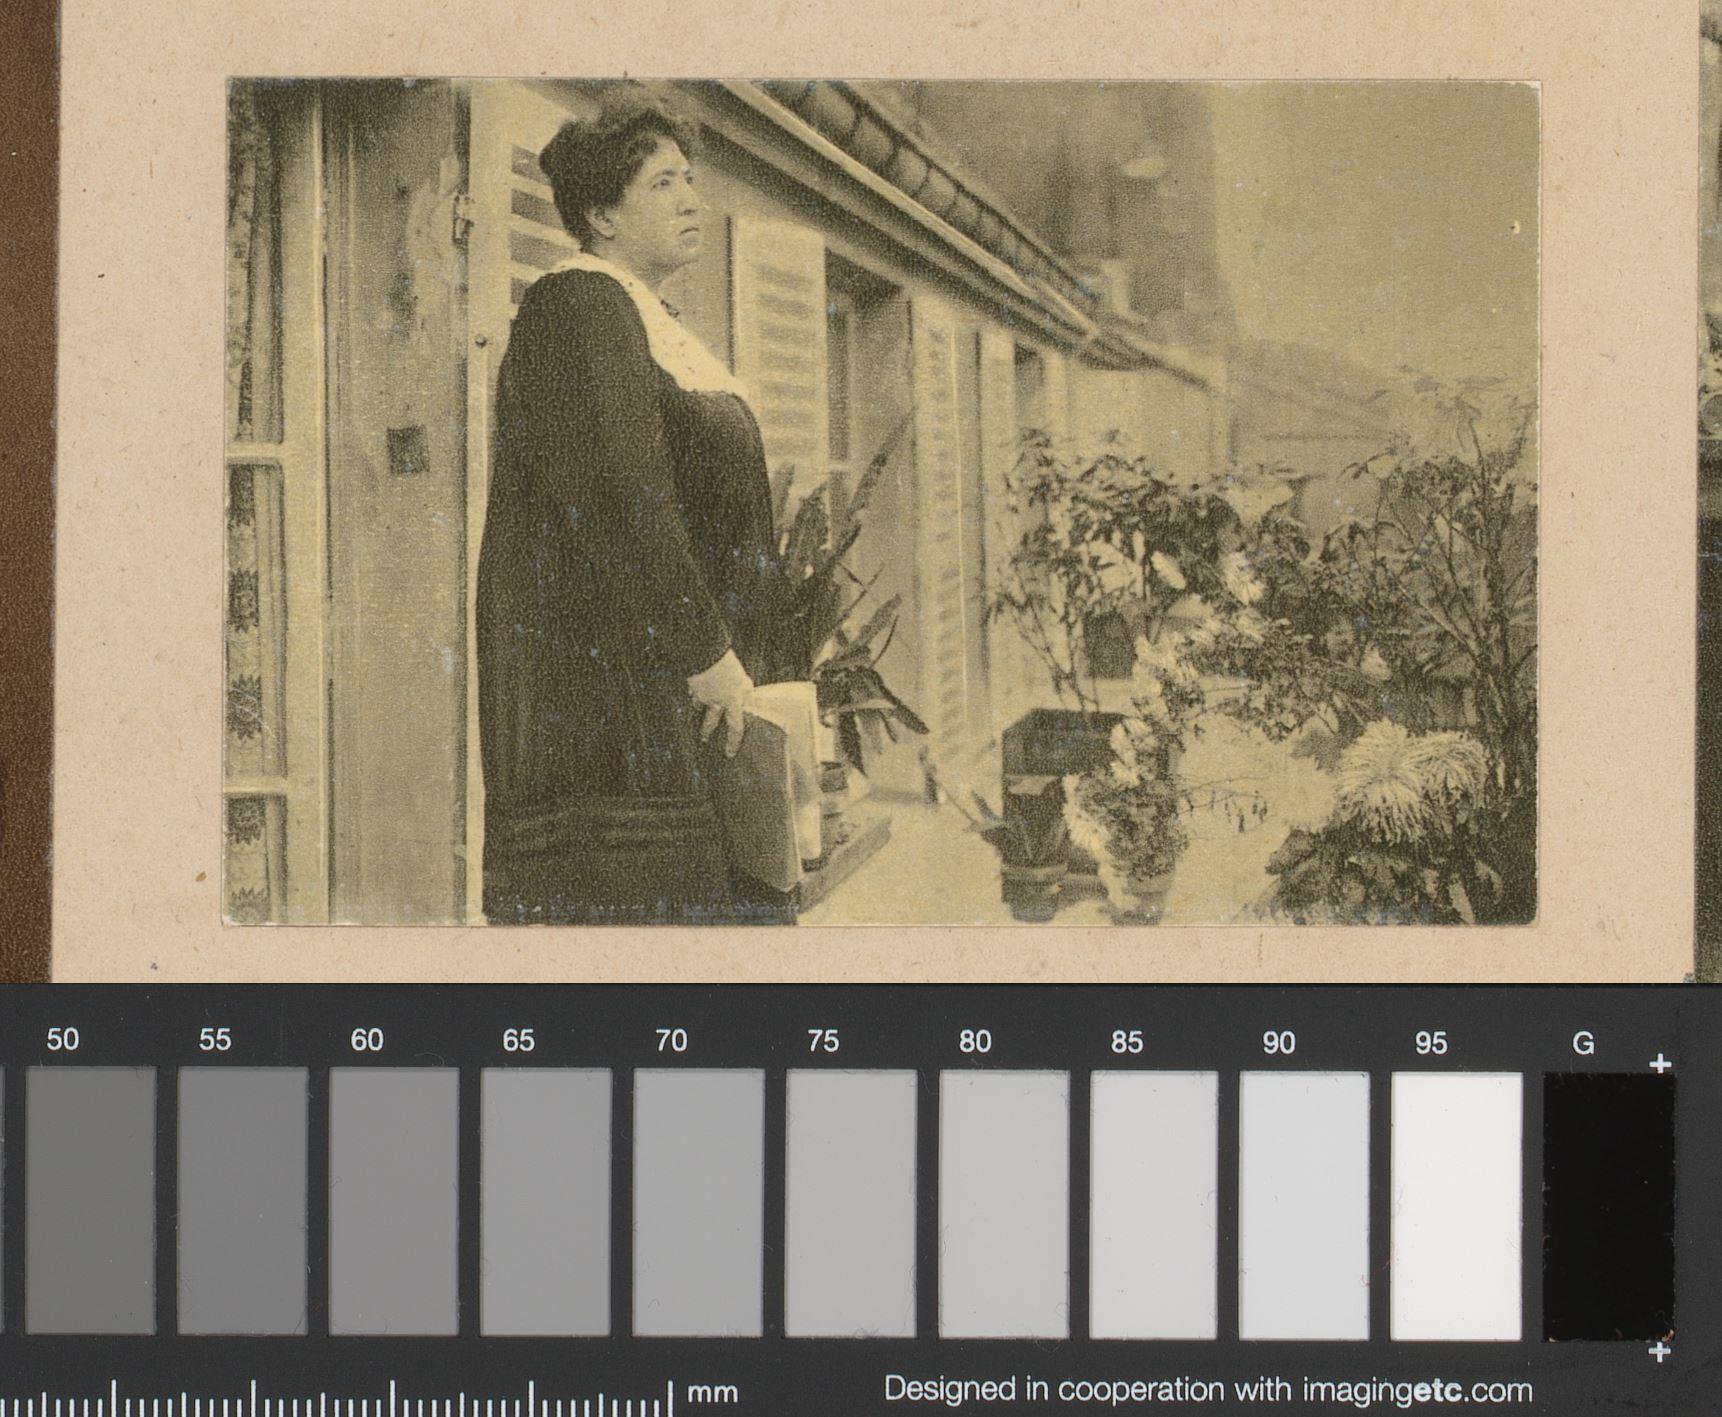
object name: album leaf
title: Judith Gautier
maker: Anonymous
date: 1900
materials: paper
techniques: rotogravure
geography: france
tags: paris, writer, poet, author, france